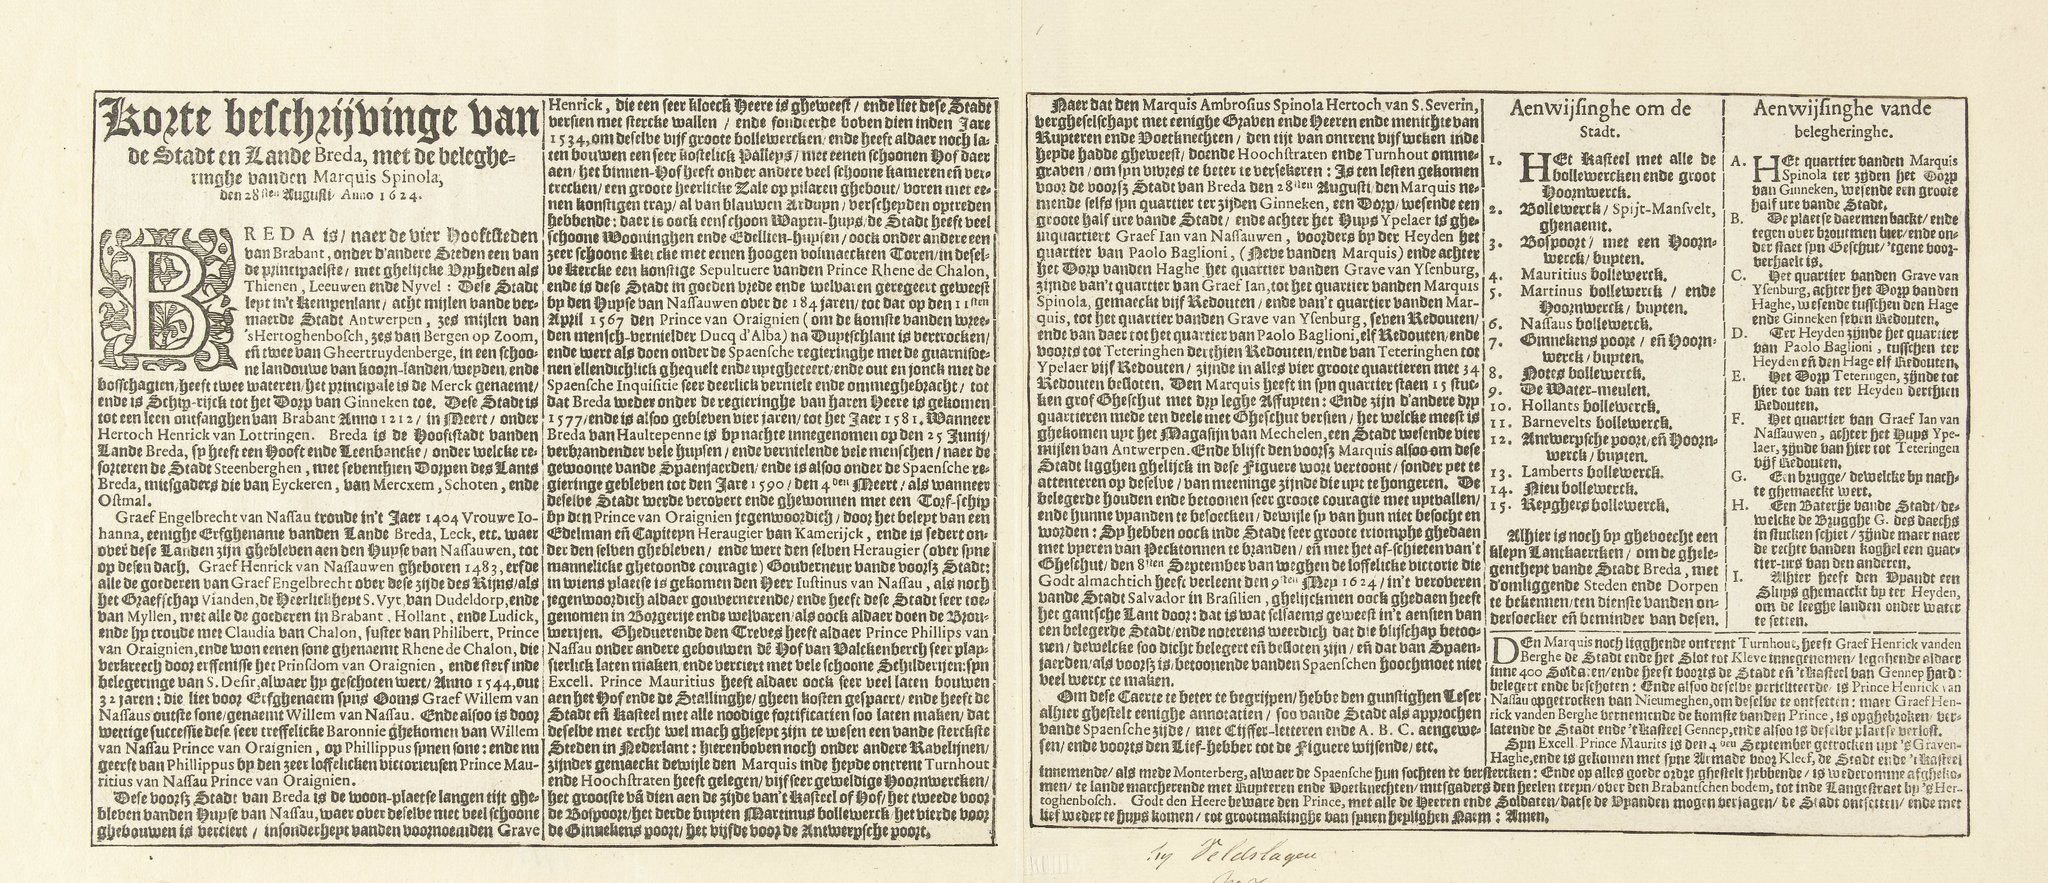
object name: print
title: Tekstblad bij een kaart van het beleg van Breda, 1624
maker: Anonymous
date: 1624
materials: paper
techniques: letterpress printing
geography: northern netherlands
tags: genua, ambrogio spinola (markies de los balbases), breda, beleg van breda (1624-1625)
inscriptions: inscription: ‘by Veldslagen No. 700’, collector's mark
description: Tekstblad bij een onbekende kaart van het beleg van Breda door het Spaanse leger onder Spinola, van 27 augustus 1624 tot 5 juni 1625. Twee bladen elk met 2 kolommen tekst in het Nederlands. Op het rechterblad de legenda's 1-25 en A-I. De kaart zelf ontbreekt.